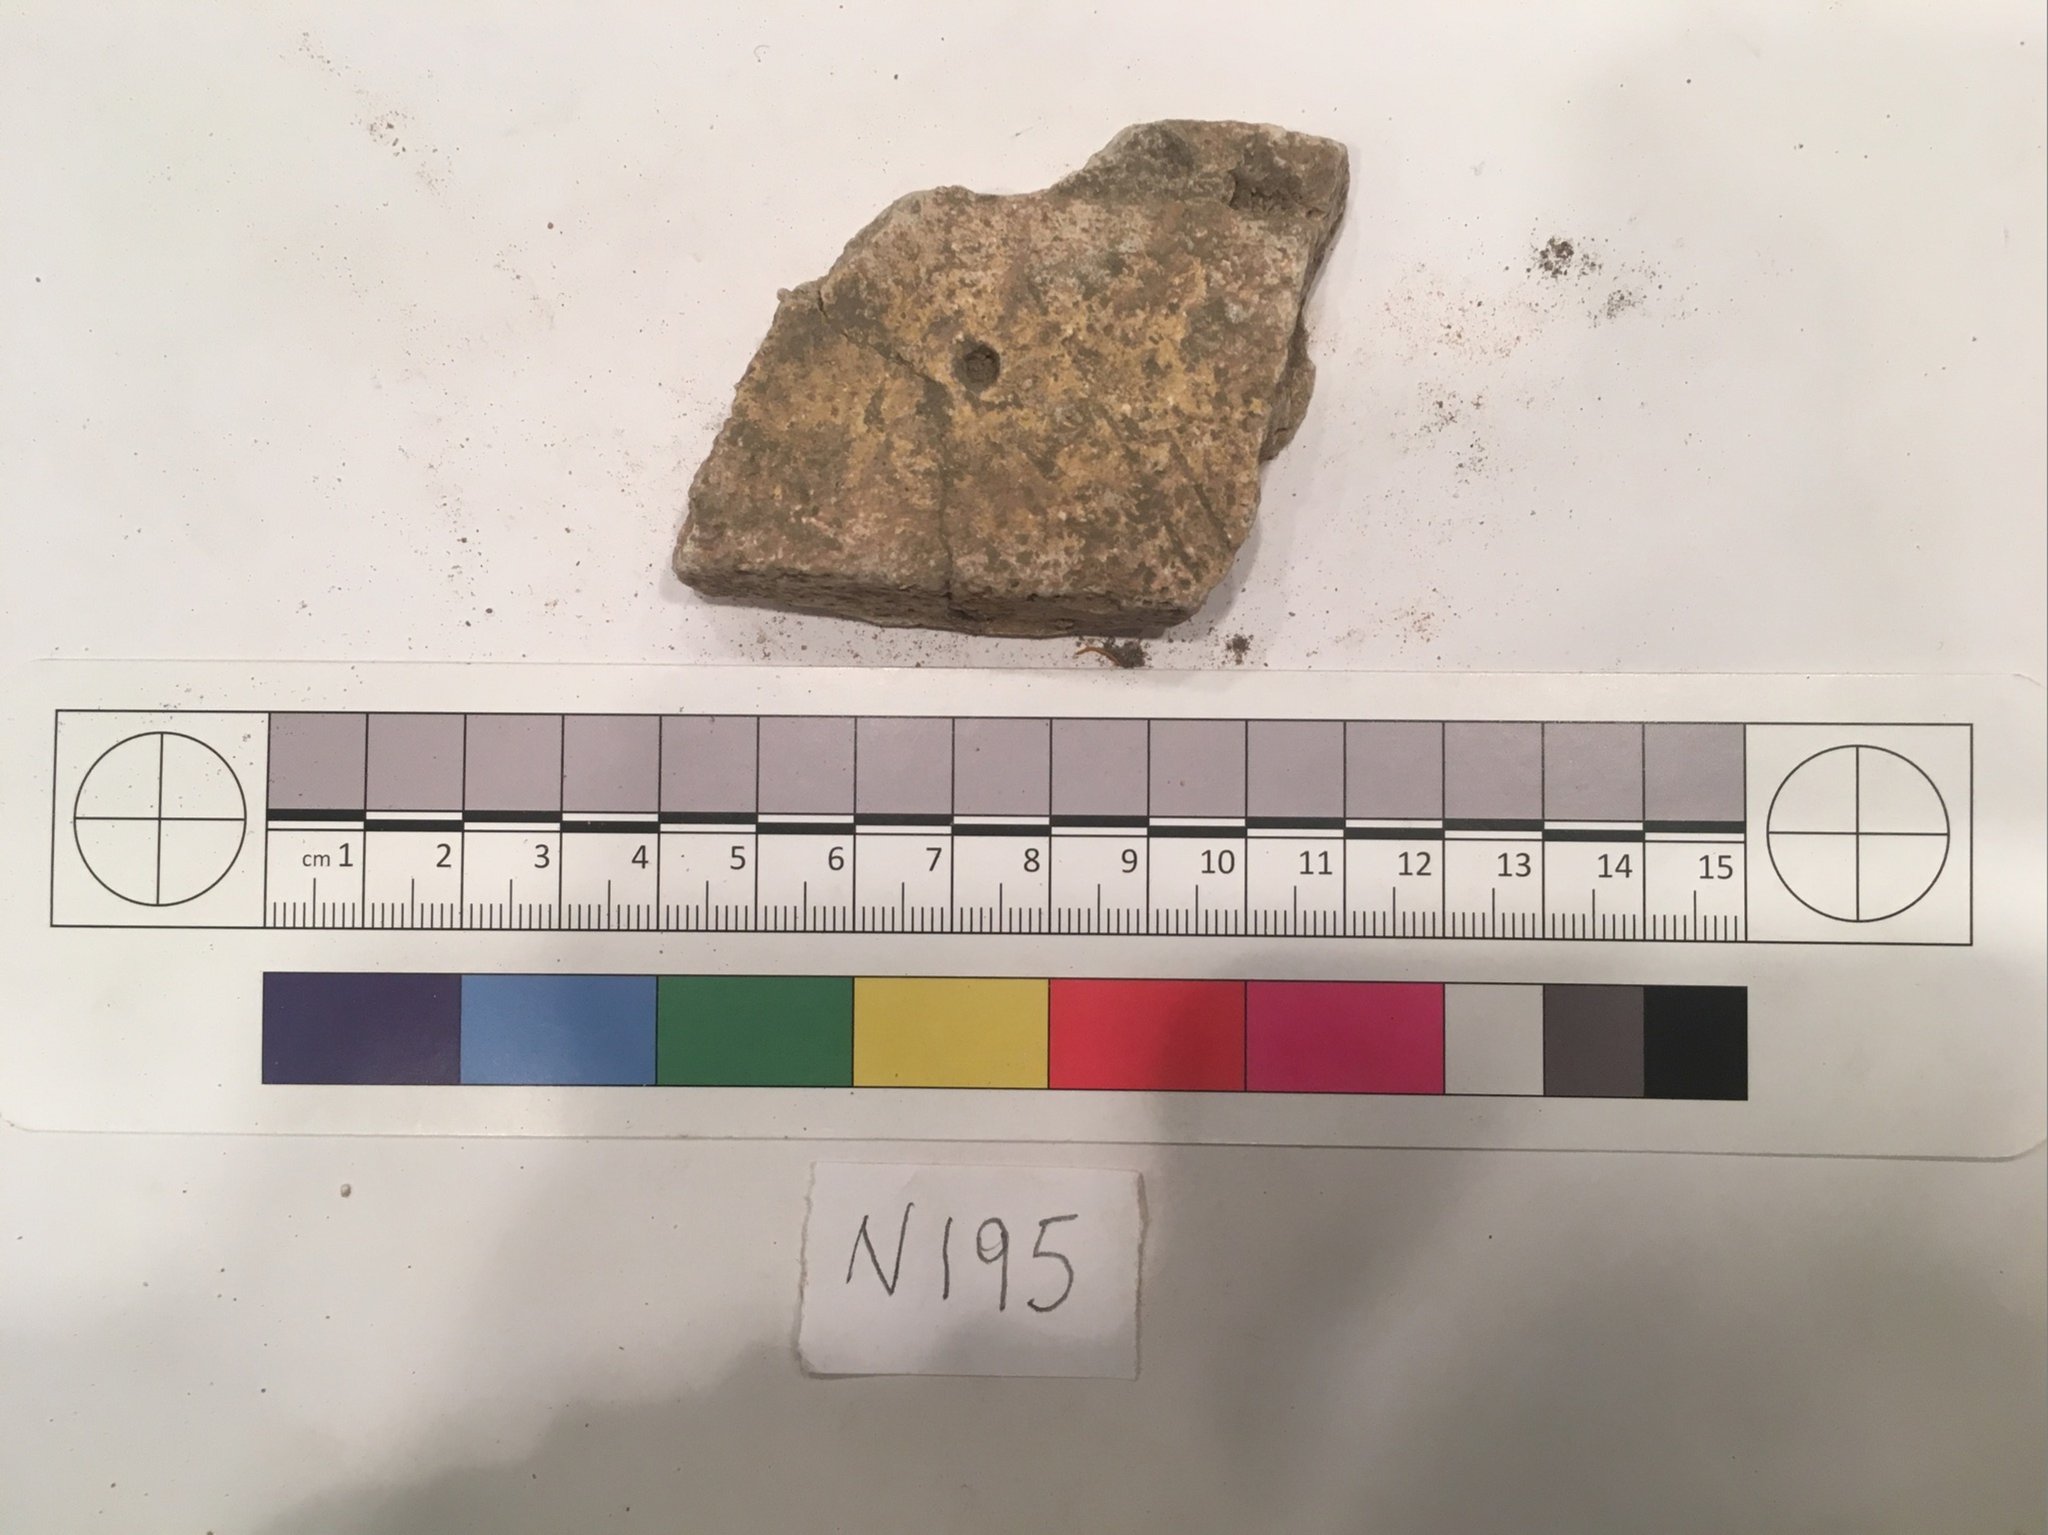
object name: fragment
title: Stucco Fragment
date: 701-1200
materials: plaster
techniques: carving, painting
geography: iran